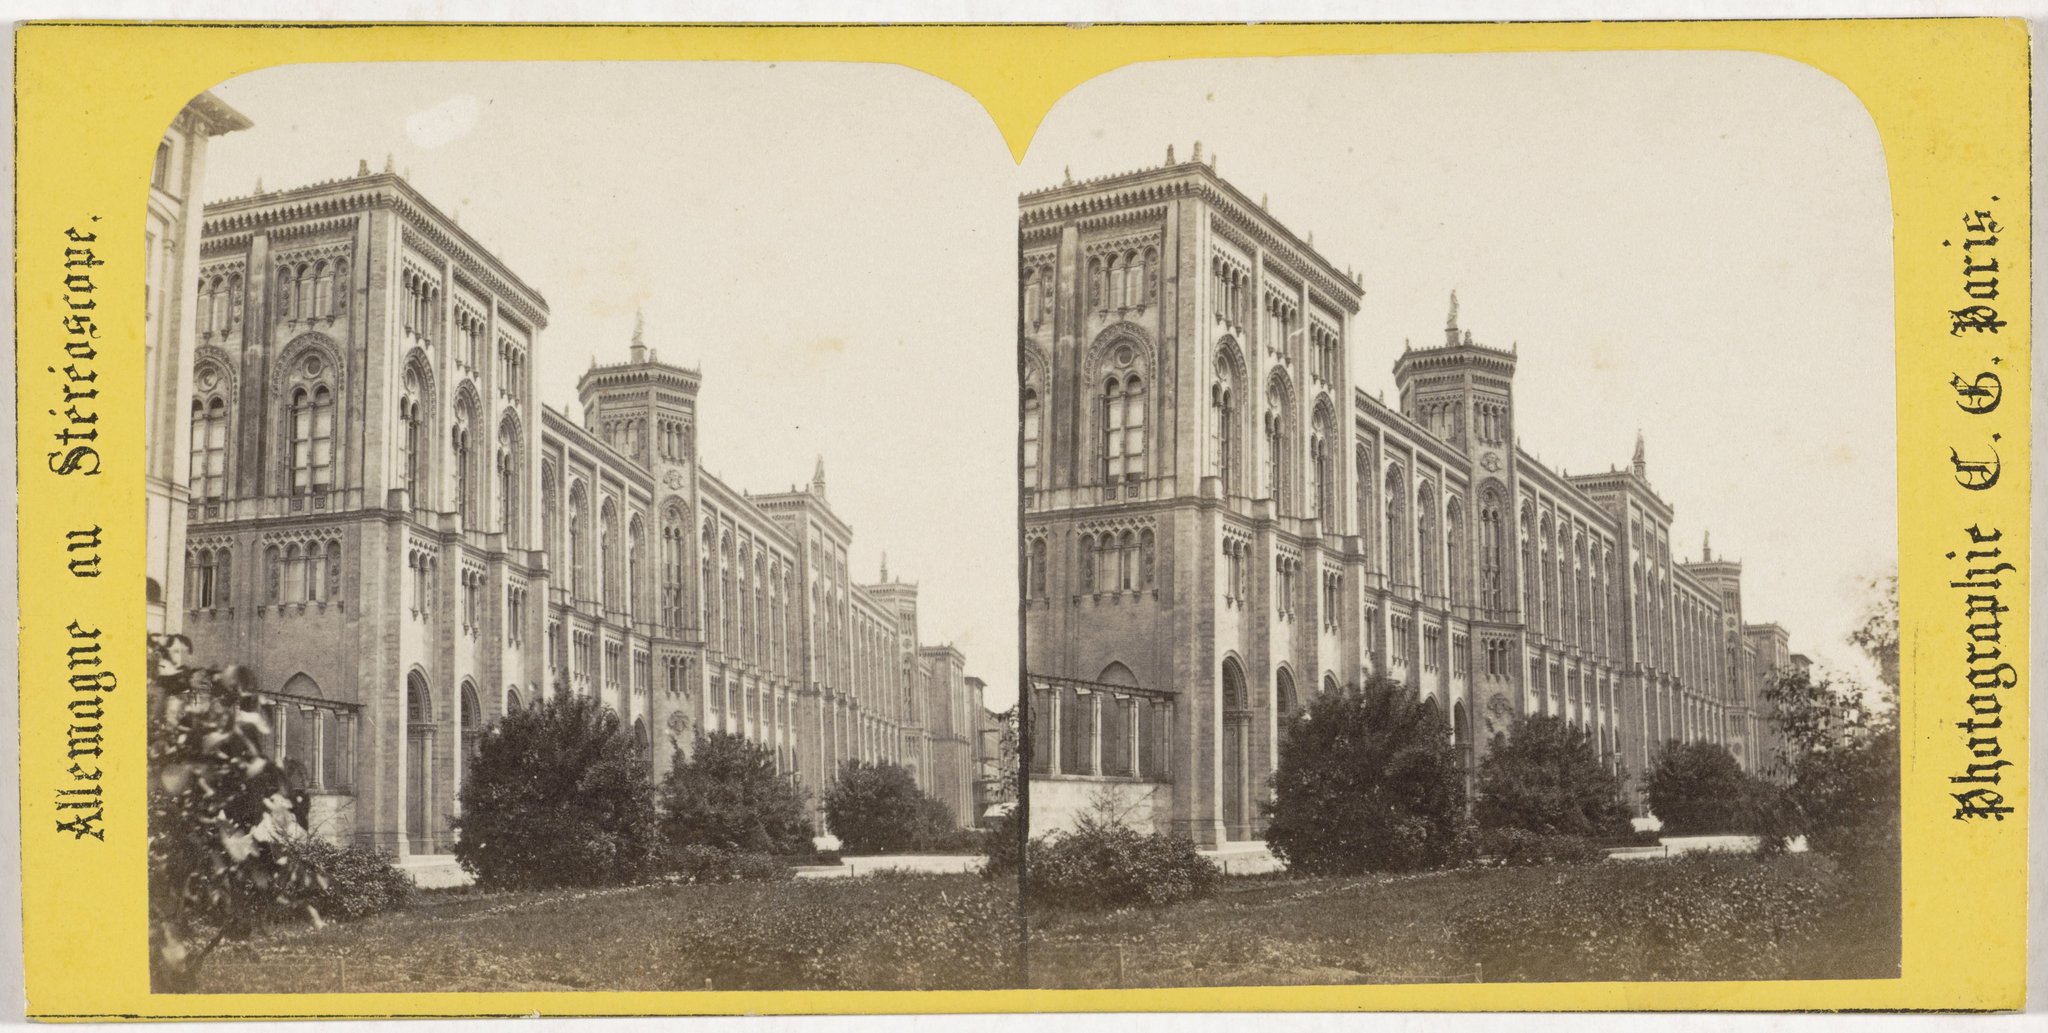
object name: stereograph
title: Gebouwen van de Beierse regering in München, Duitsland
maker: charles gaudin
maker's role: publisher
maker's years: 1825-1905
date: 1868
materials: cardboard, paper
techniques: albumen print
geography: munich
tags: provincial government, representation of real building (either existing or having existed)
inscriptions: number: ‘35.’, inscription: ‘60’, inscription: ‘35’